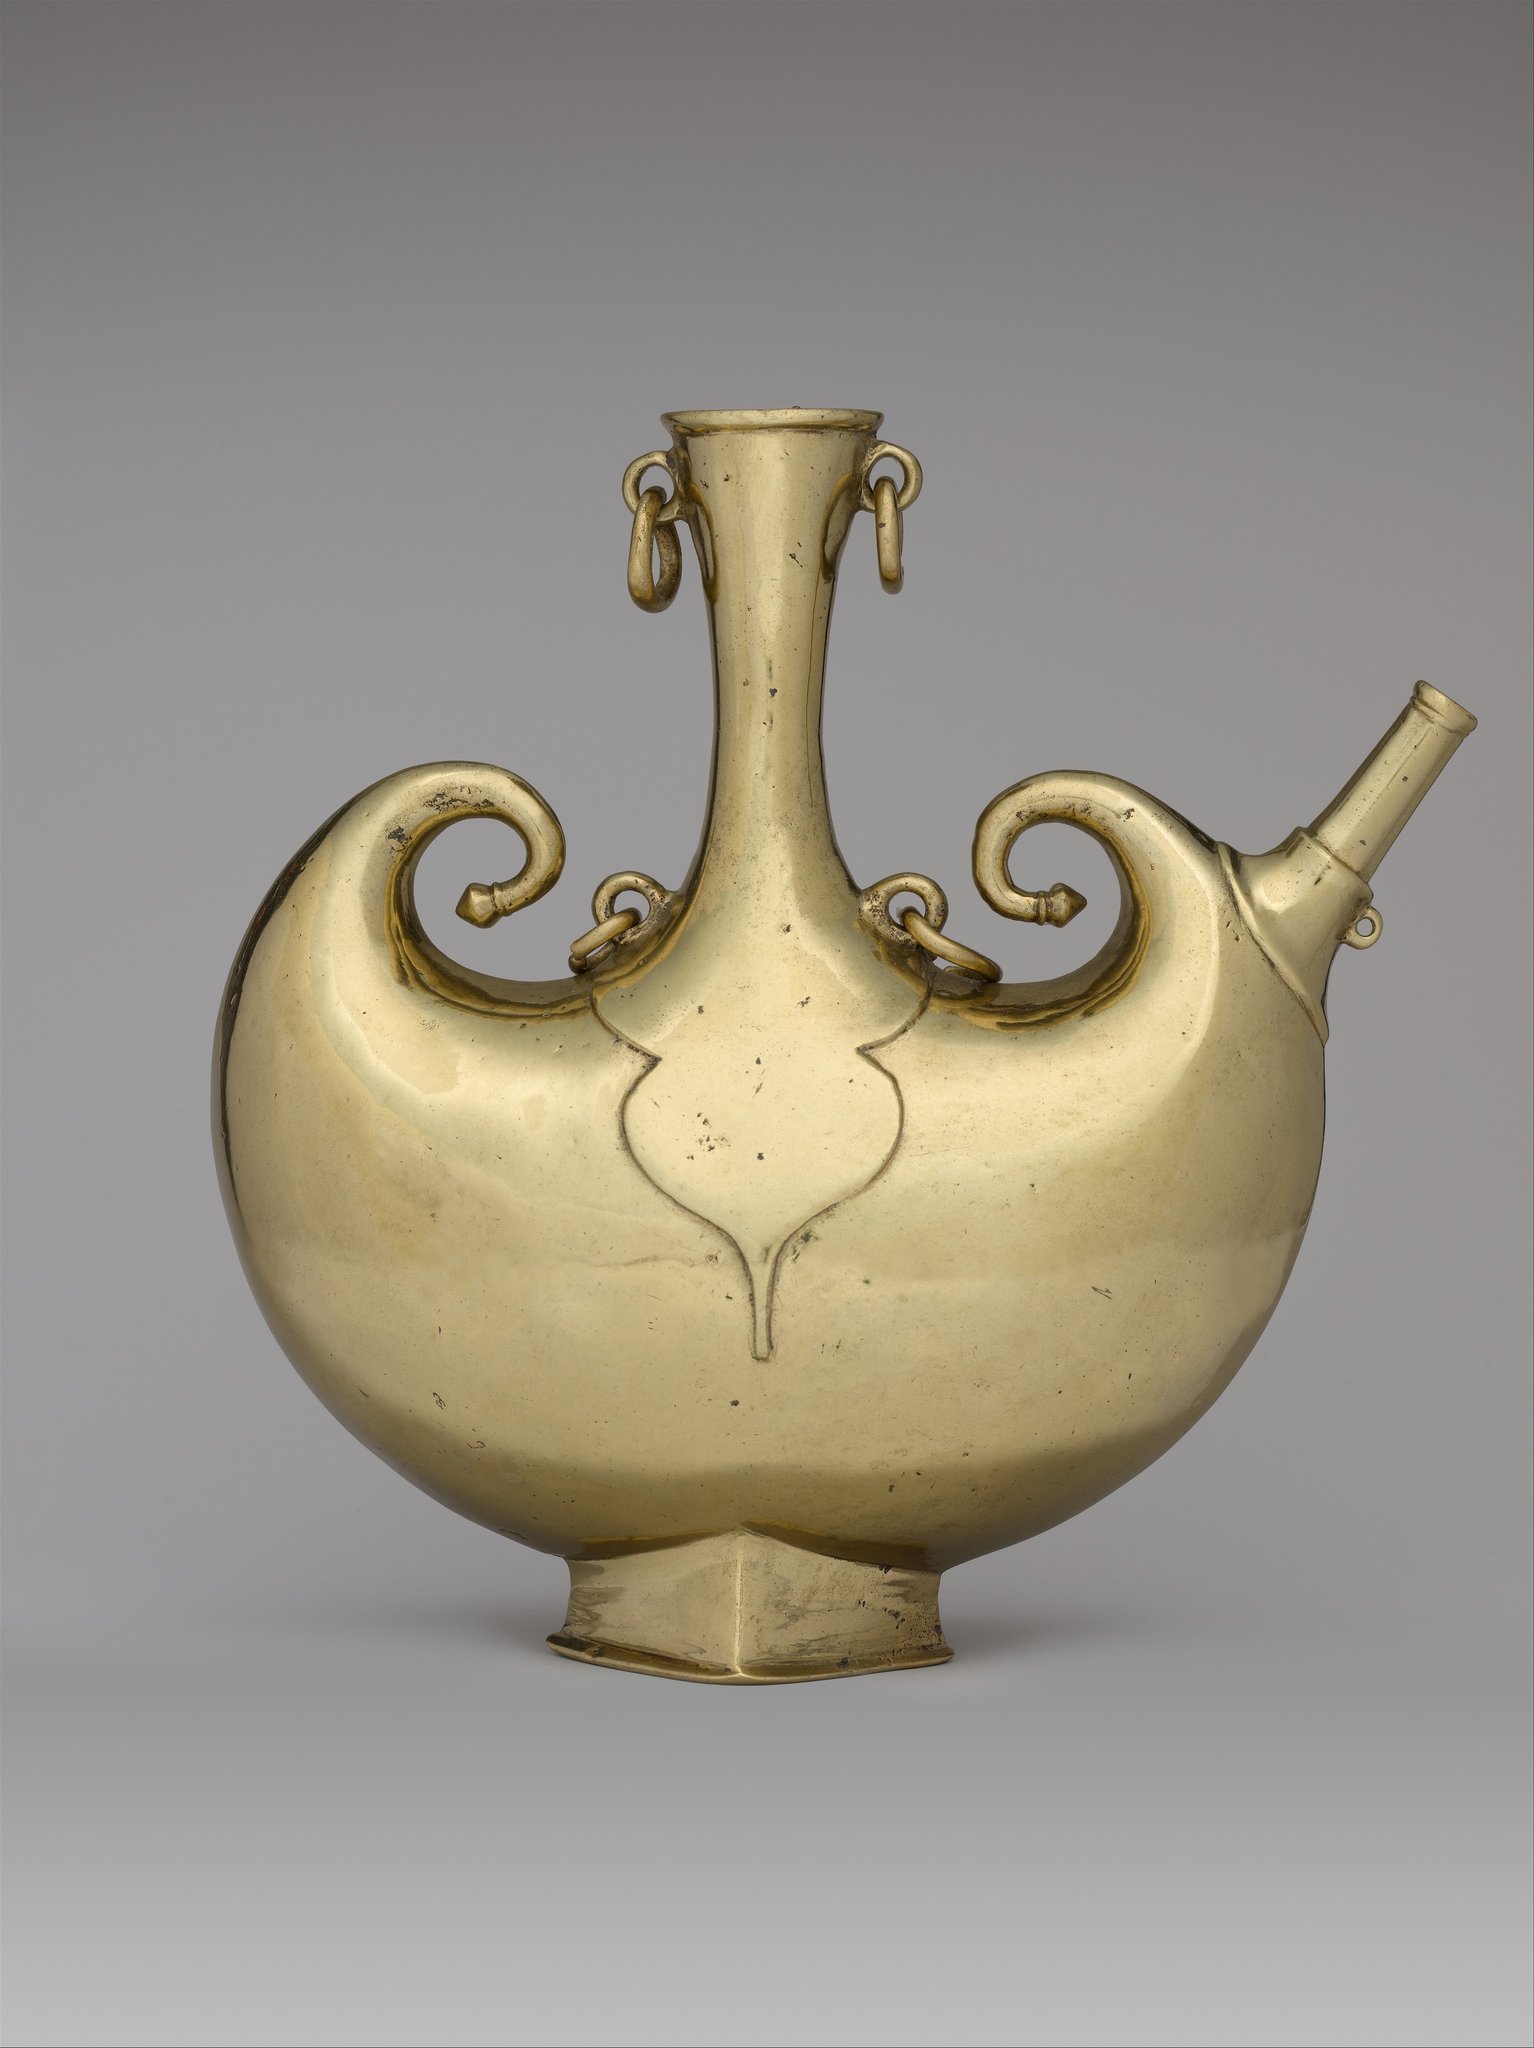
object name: pilgrim flask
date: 1601-1633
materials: brass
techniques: casting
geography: india